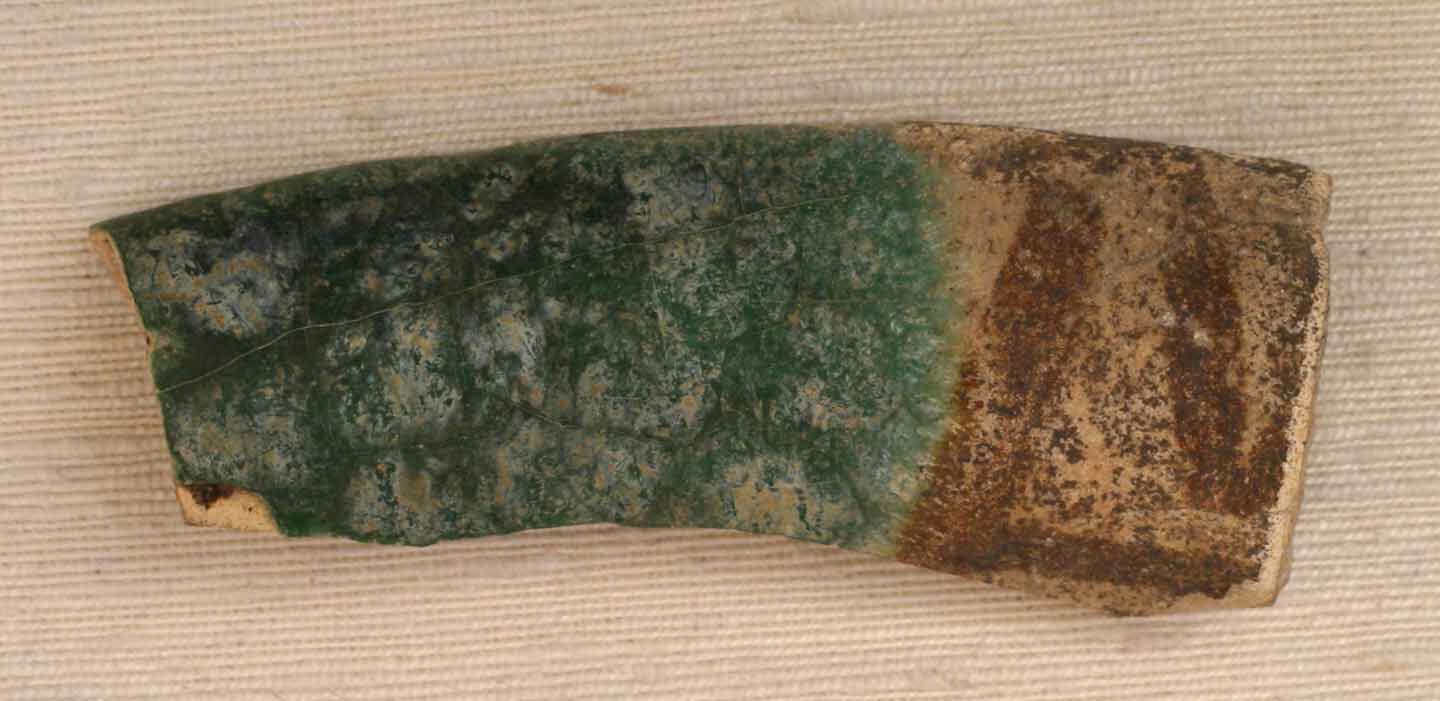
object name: fragment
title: Glazed Ceramic Fragments: Splashed, Opacified White, and Green Glazed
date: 801-900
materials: earthenware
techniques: glazing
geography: iraq